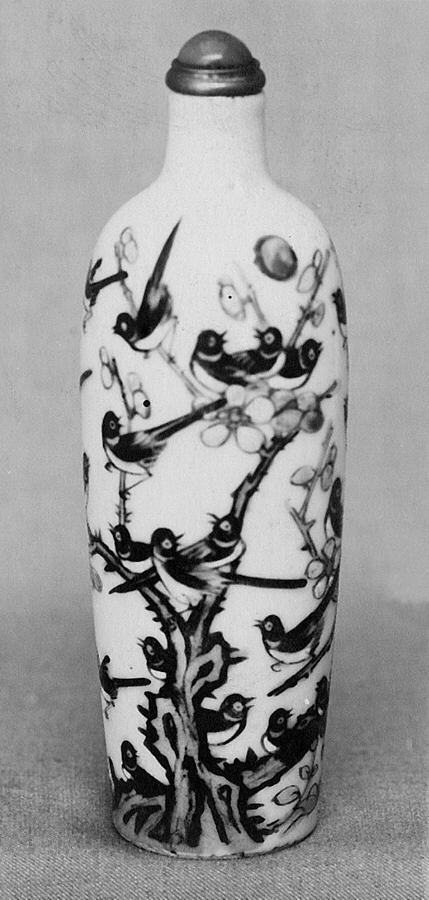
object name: snuff bottle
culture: chinese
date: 1736-1795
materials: porcelain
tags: birds